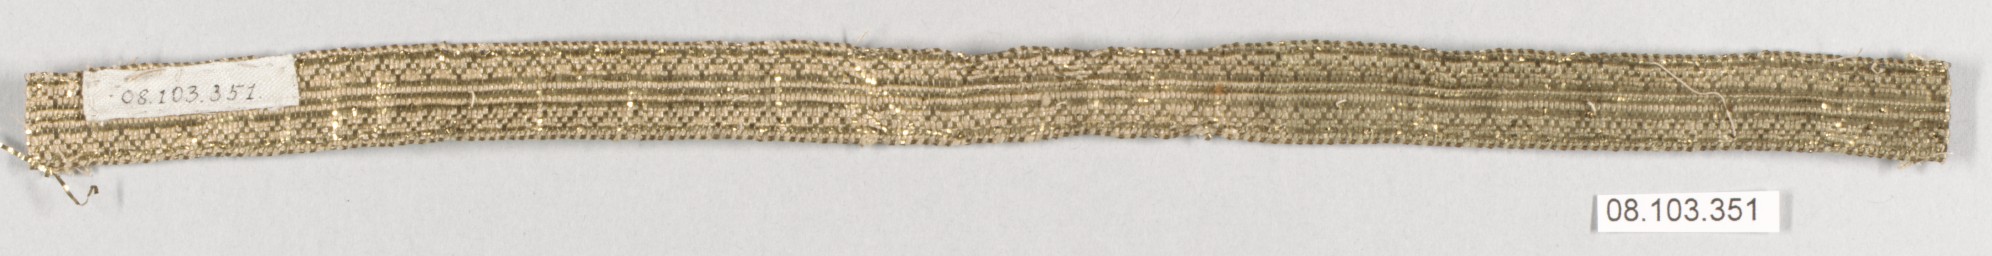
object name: galloon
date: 1601-1800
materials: metal thread